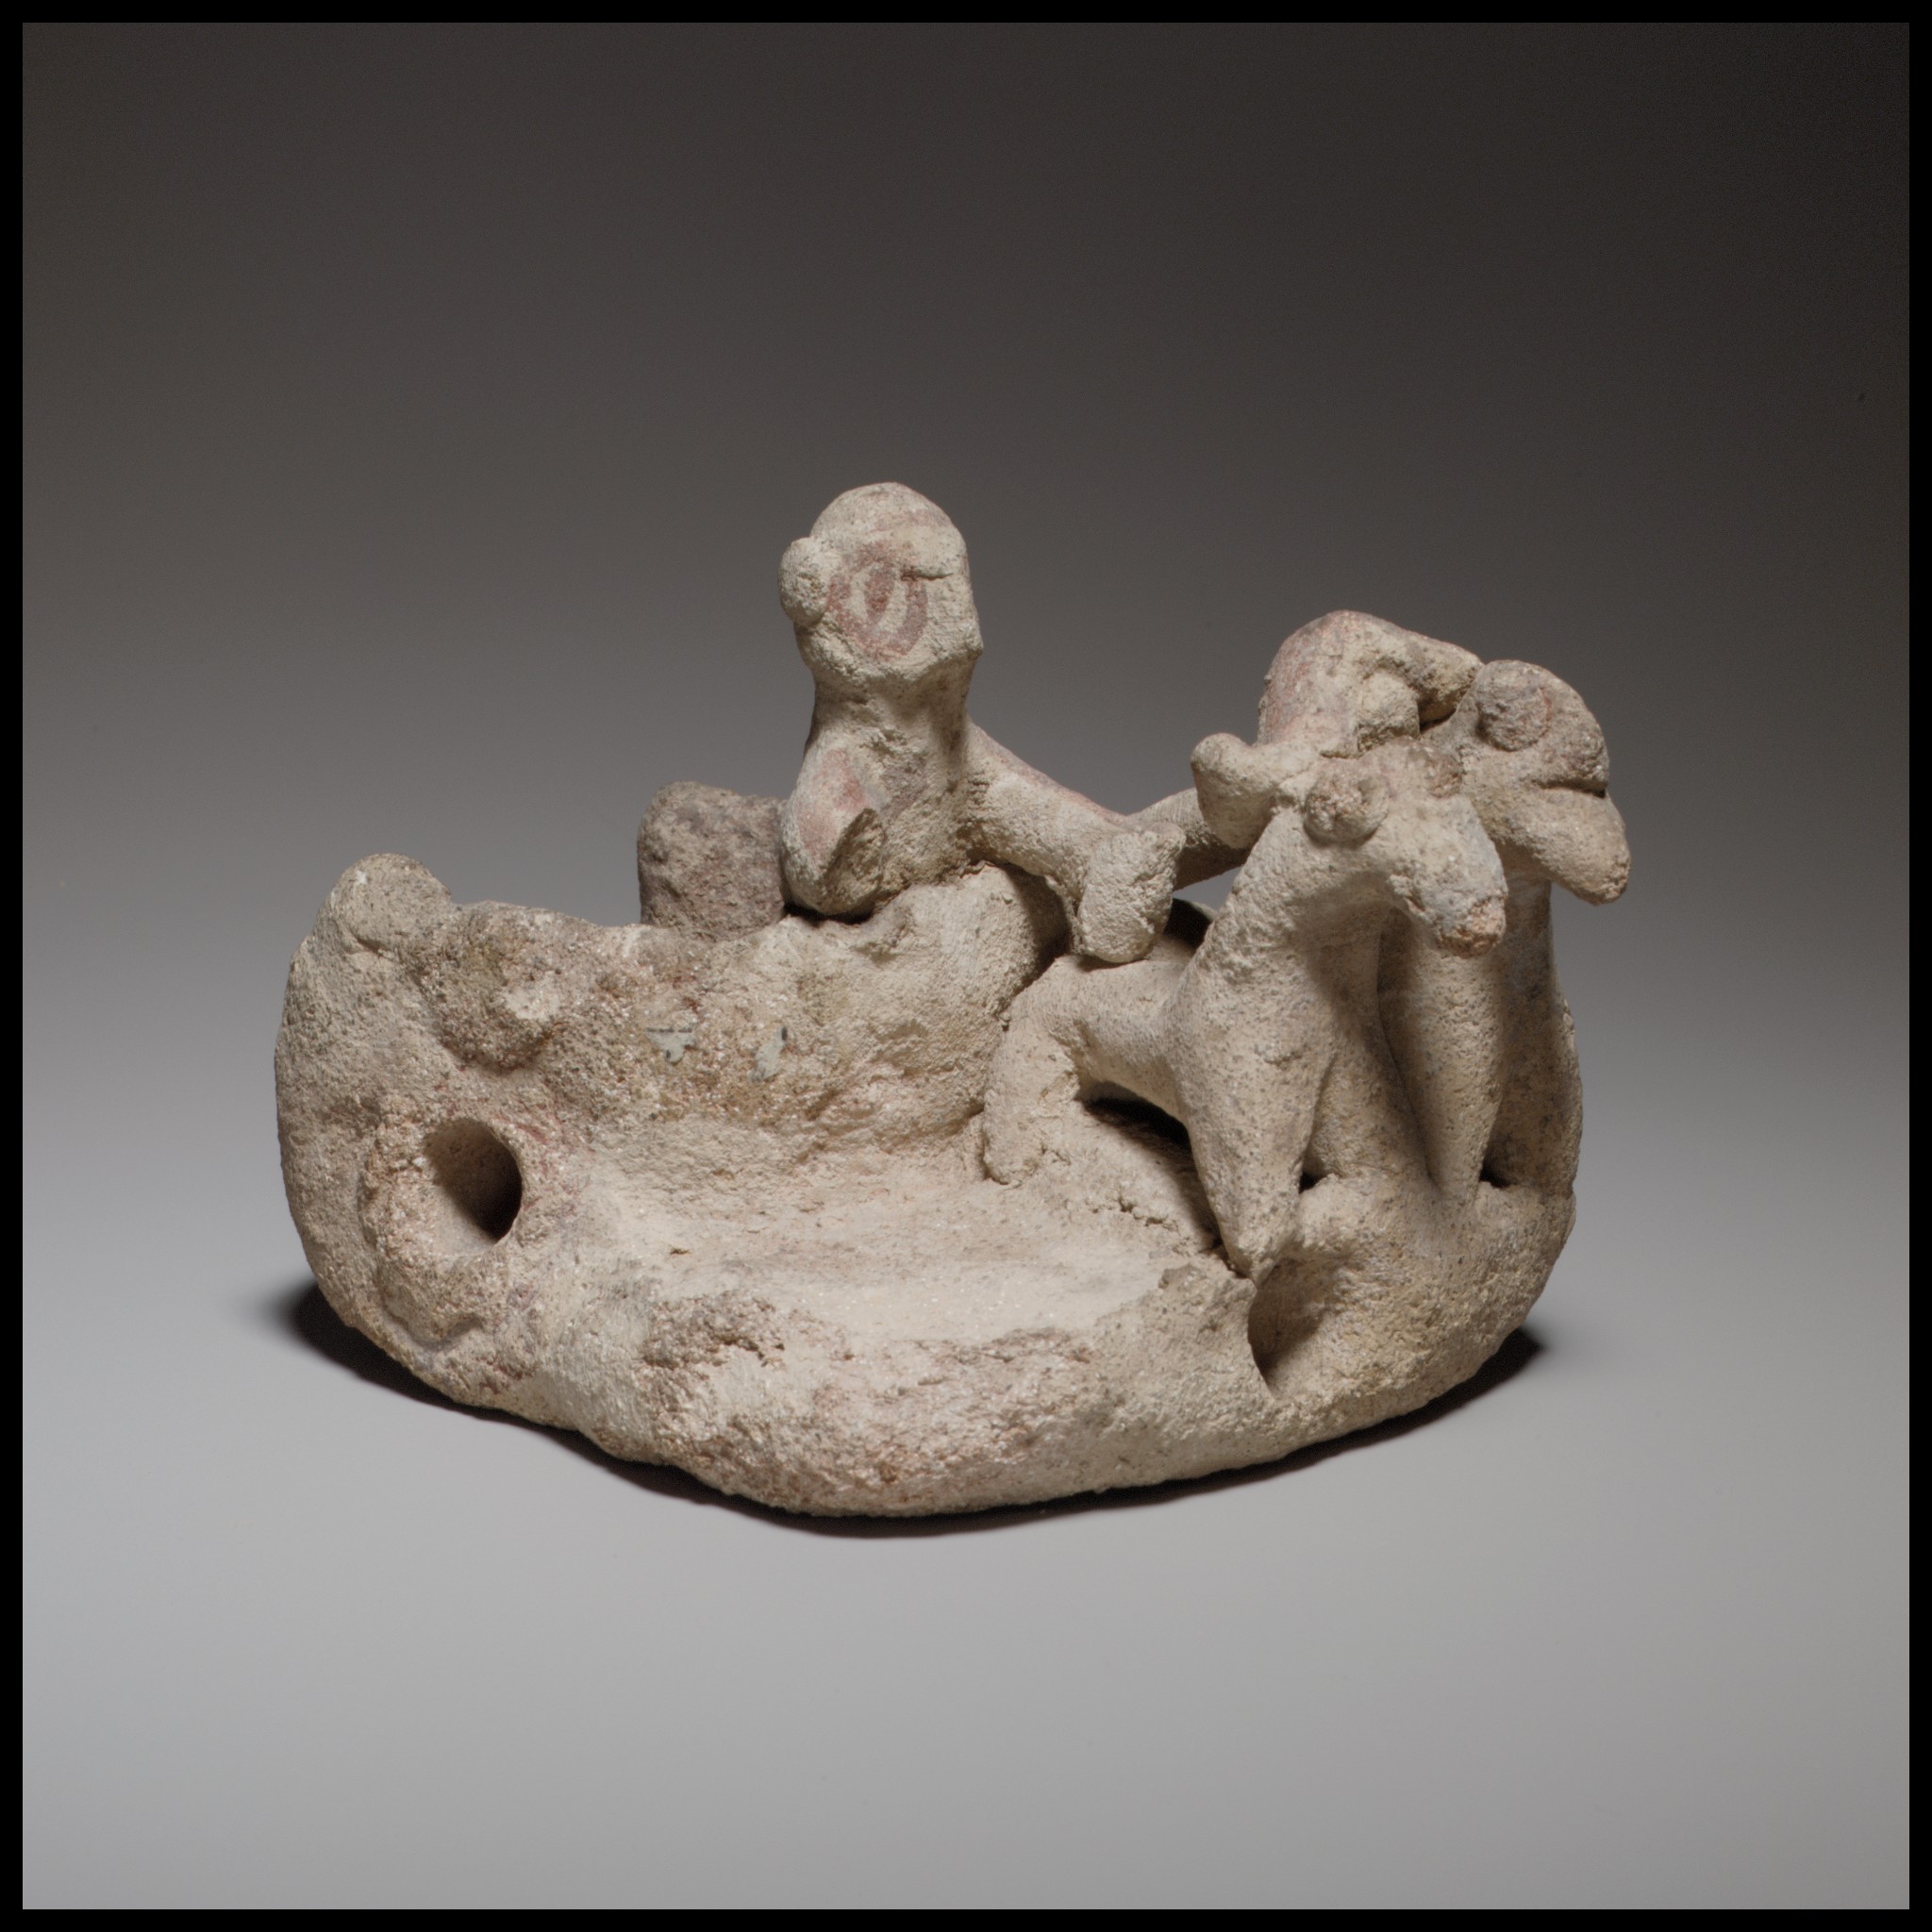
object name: model of a chariot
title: Chariot group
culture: cypriot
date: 600-480 BCE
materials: terracotta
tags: human figures,horses,chariots